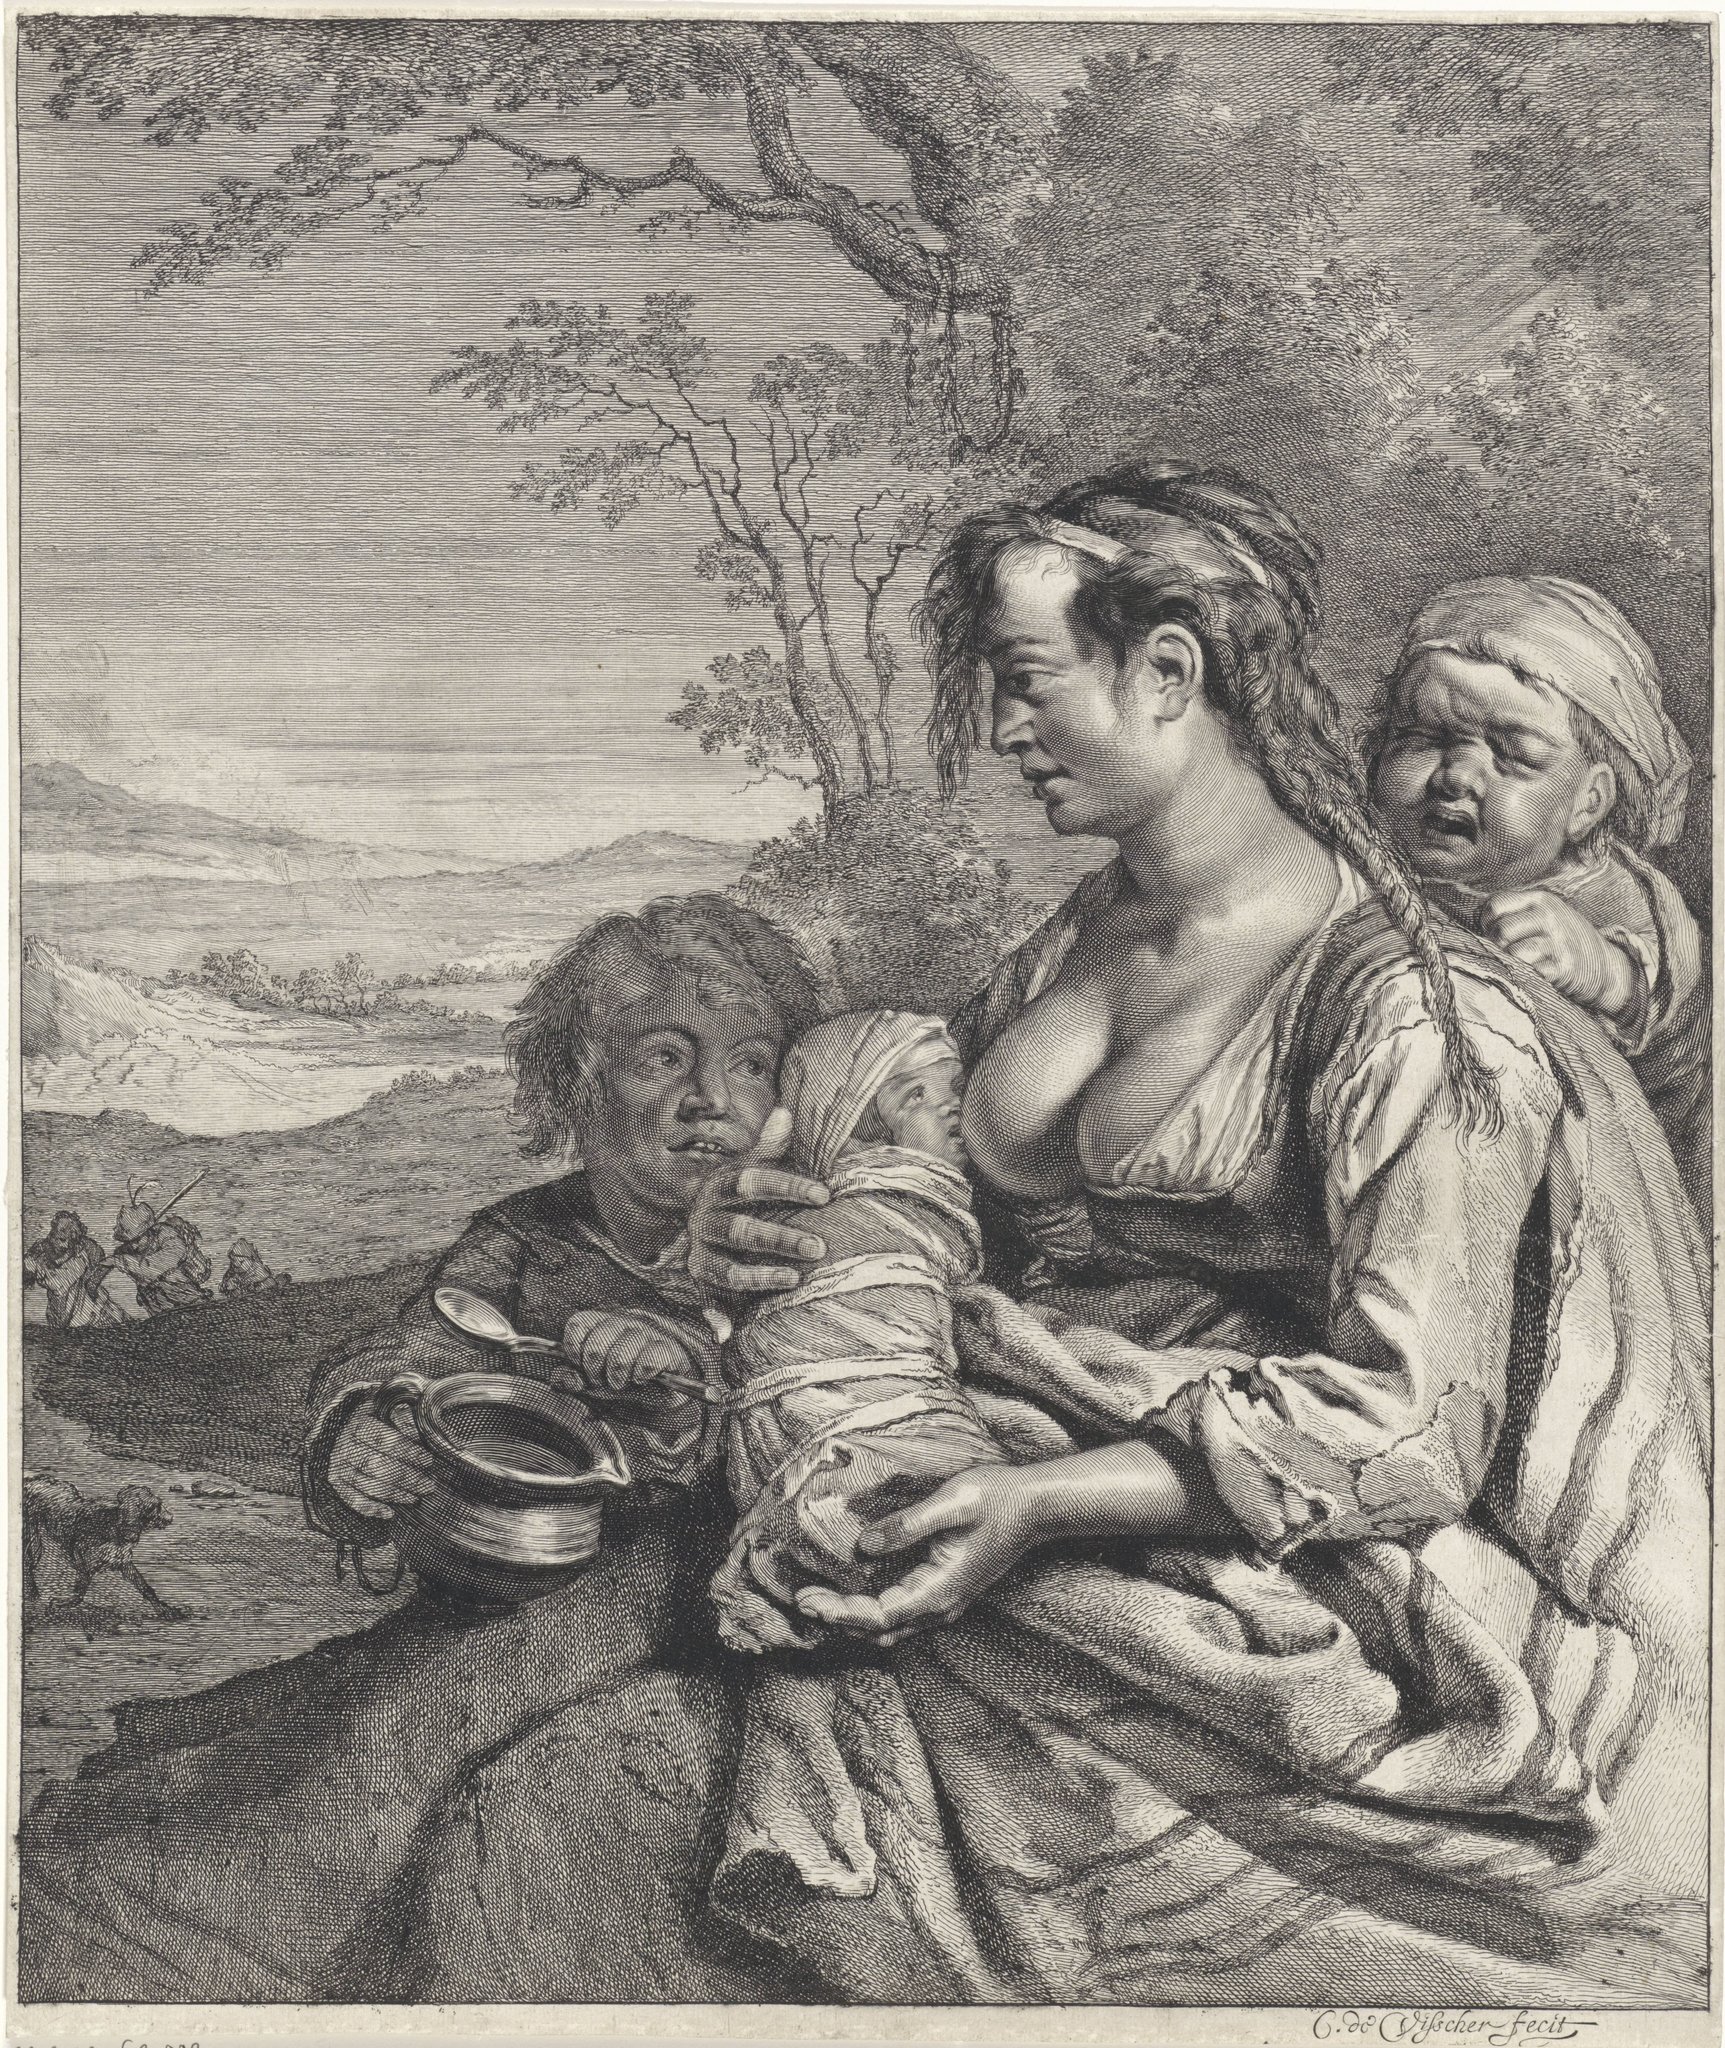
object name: print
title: Roma vrouw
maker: cornelis visscher (ii)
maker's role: draughtsman, painter, print maker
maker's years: 1628-1658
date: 1638-1658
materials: paper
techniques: engraving, etching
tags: nursing, suckling, wandering communities: romani or roma, weeping, 'en route', traveller under way, dog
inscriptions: collector's mark: Lugt 240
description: In een heuvelachtig landschap geeft een Roma vrouw haar baby de borst. Naast haar staat een jong kind met een nap en een lepel. Op haar rug een derde kind dat huilt. Op de achtergrond drie reizigers en een hond. ‘Heidens’ of ‘heidenen’ was een eigentijdse benaming voor Roma.